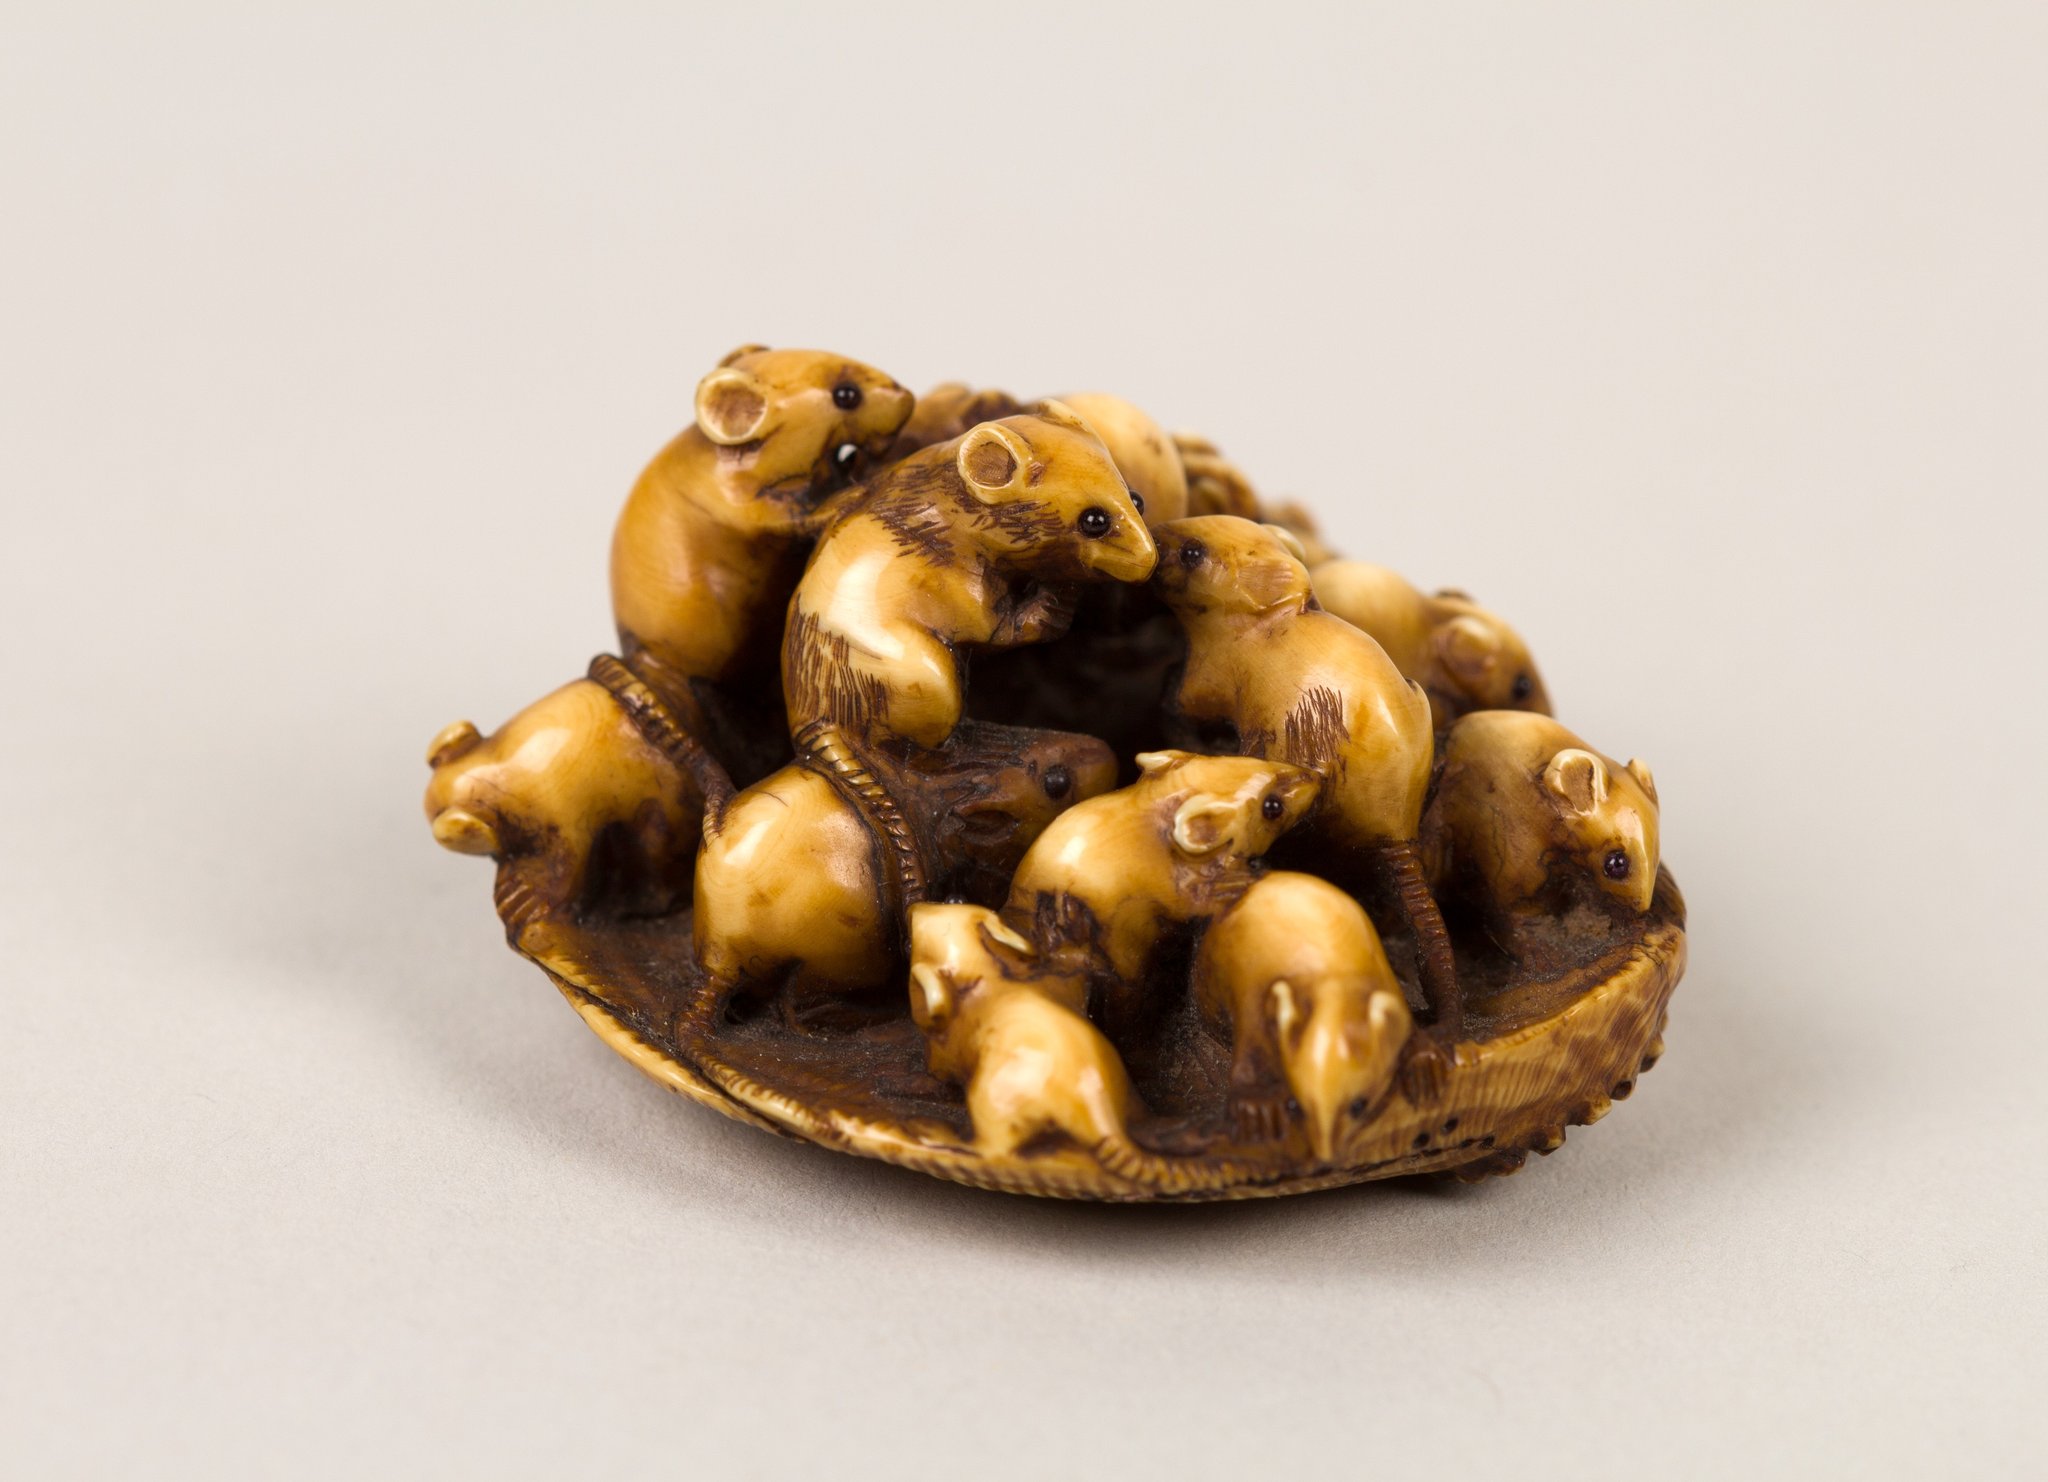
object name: netsuke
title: Netsuke of a Group of Rats Nestled in an Abalone Shell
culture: japanese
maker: masamitsu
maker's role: artist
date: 1867-1900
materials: horn, ivory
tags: mice